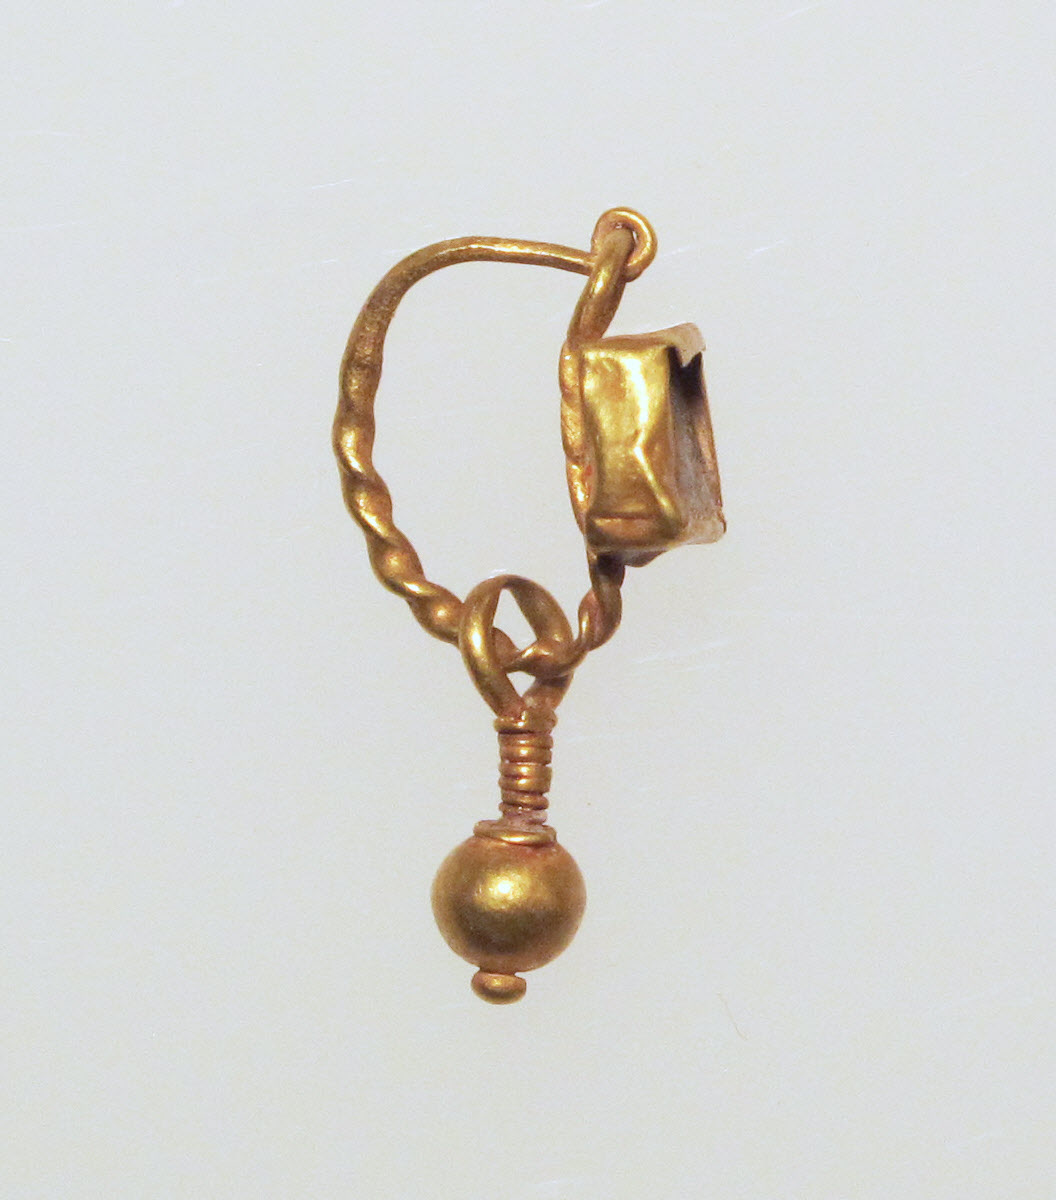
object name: earring with pendant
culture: roman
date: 1-200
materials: gold